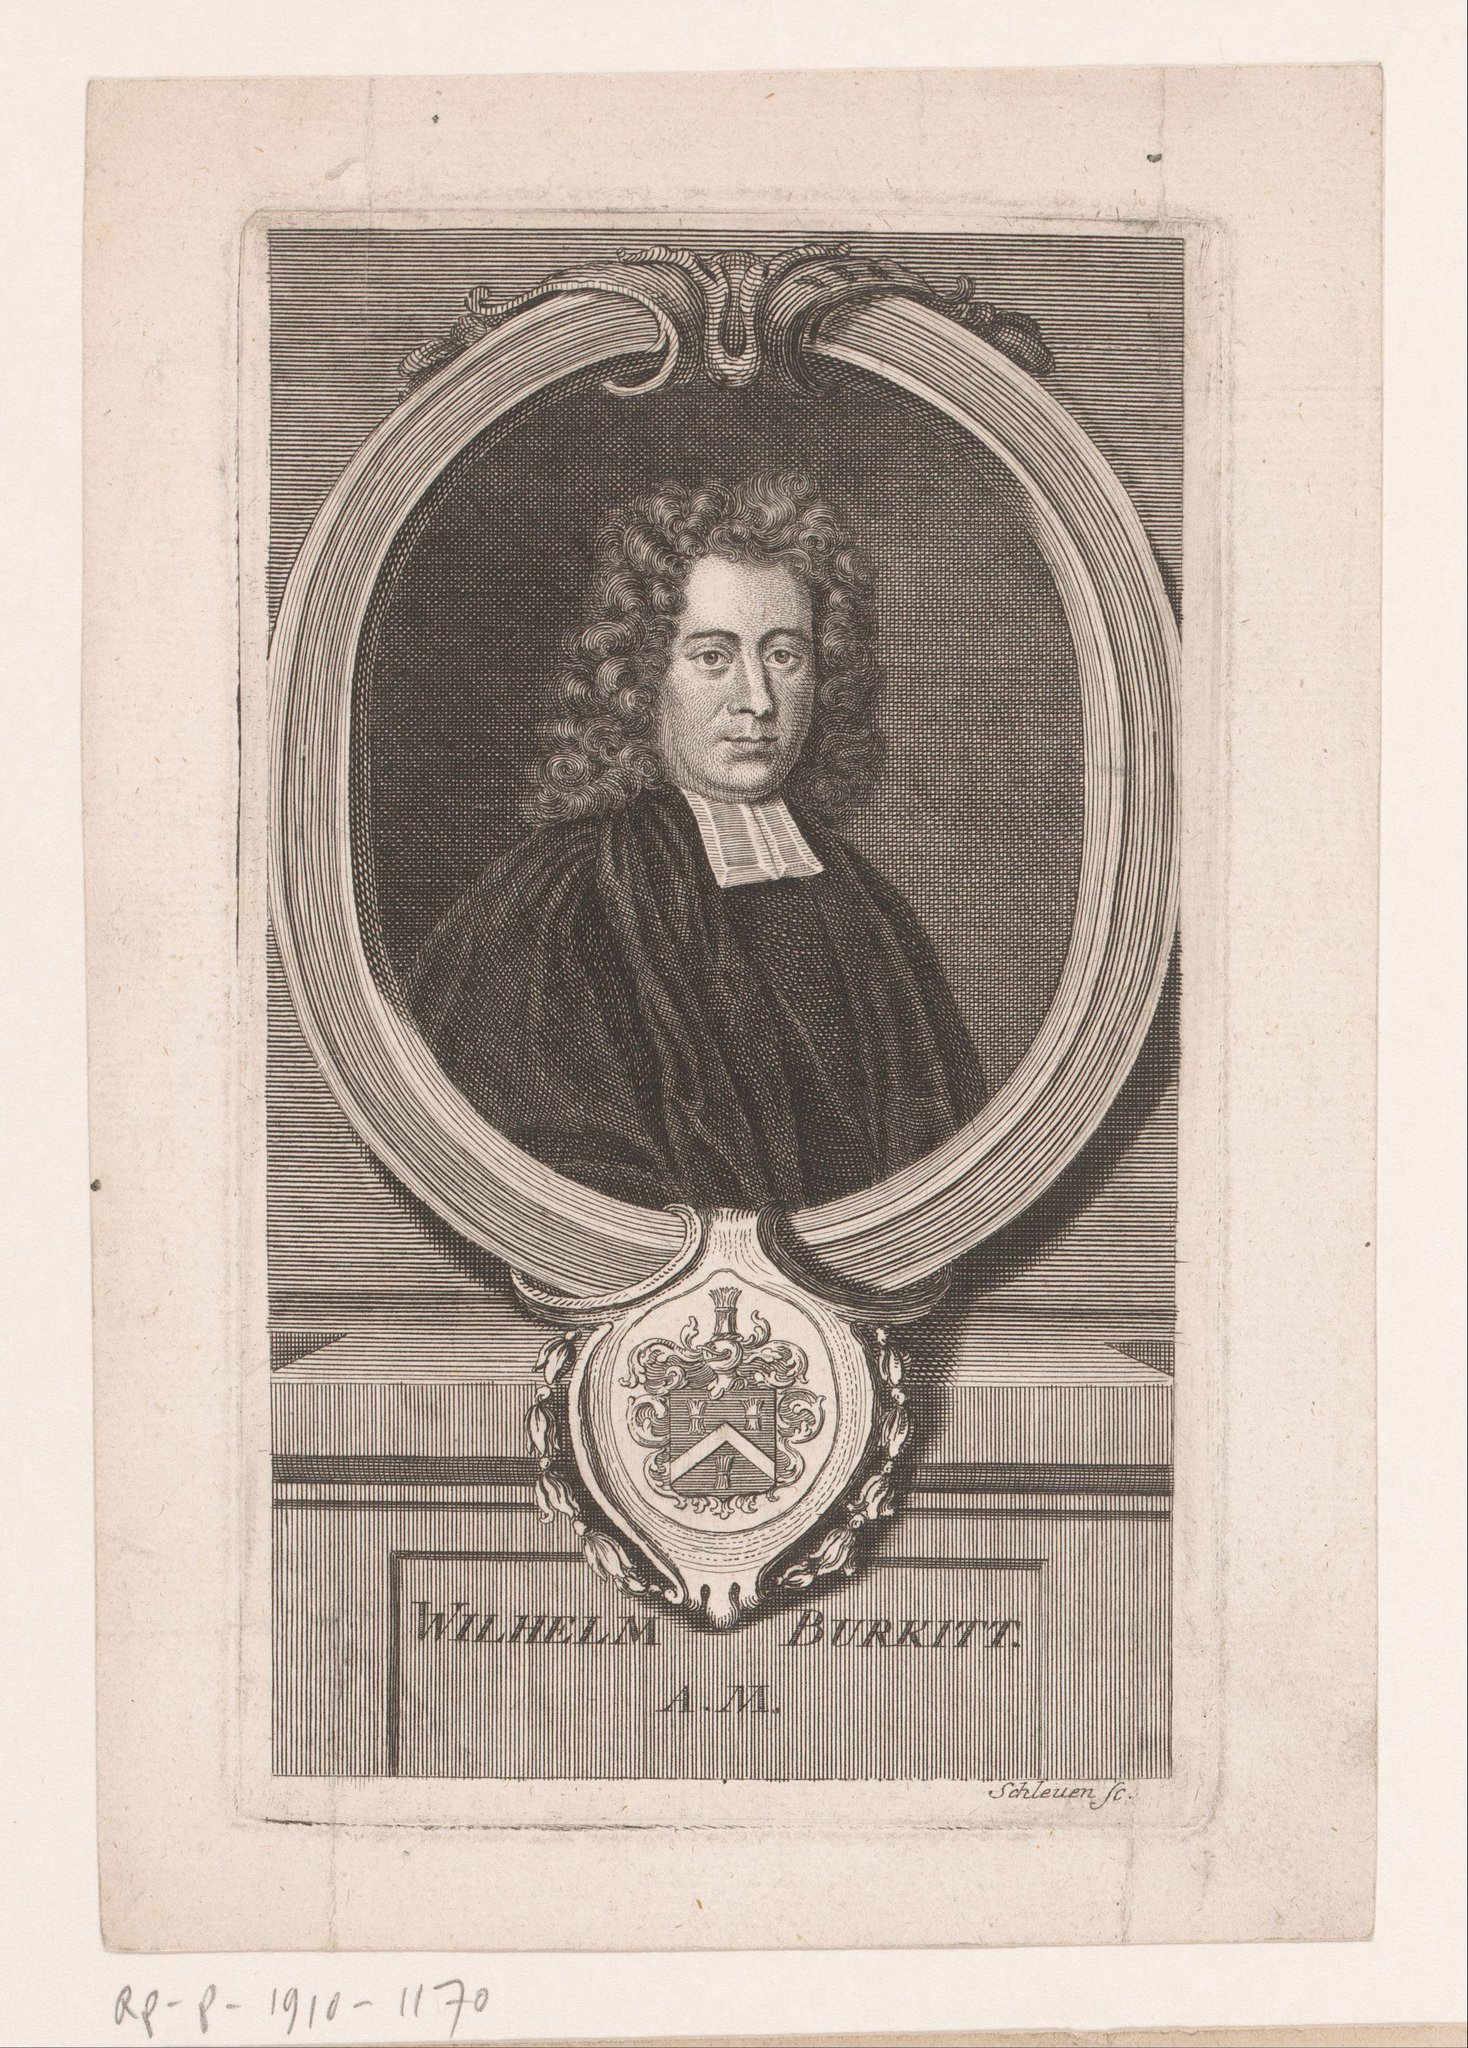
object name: print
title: Portret van William Burkitt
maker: johann friedrich schleuen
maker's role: print maker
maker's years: 1739-1784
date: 1749-1784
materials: paper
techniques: engraving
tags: theologian, historical persons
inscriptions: collector's mark: Lugt 2228